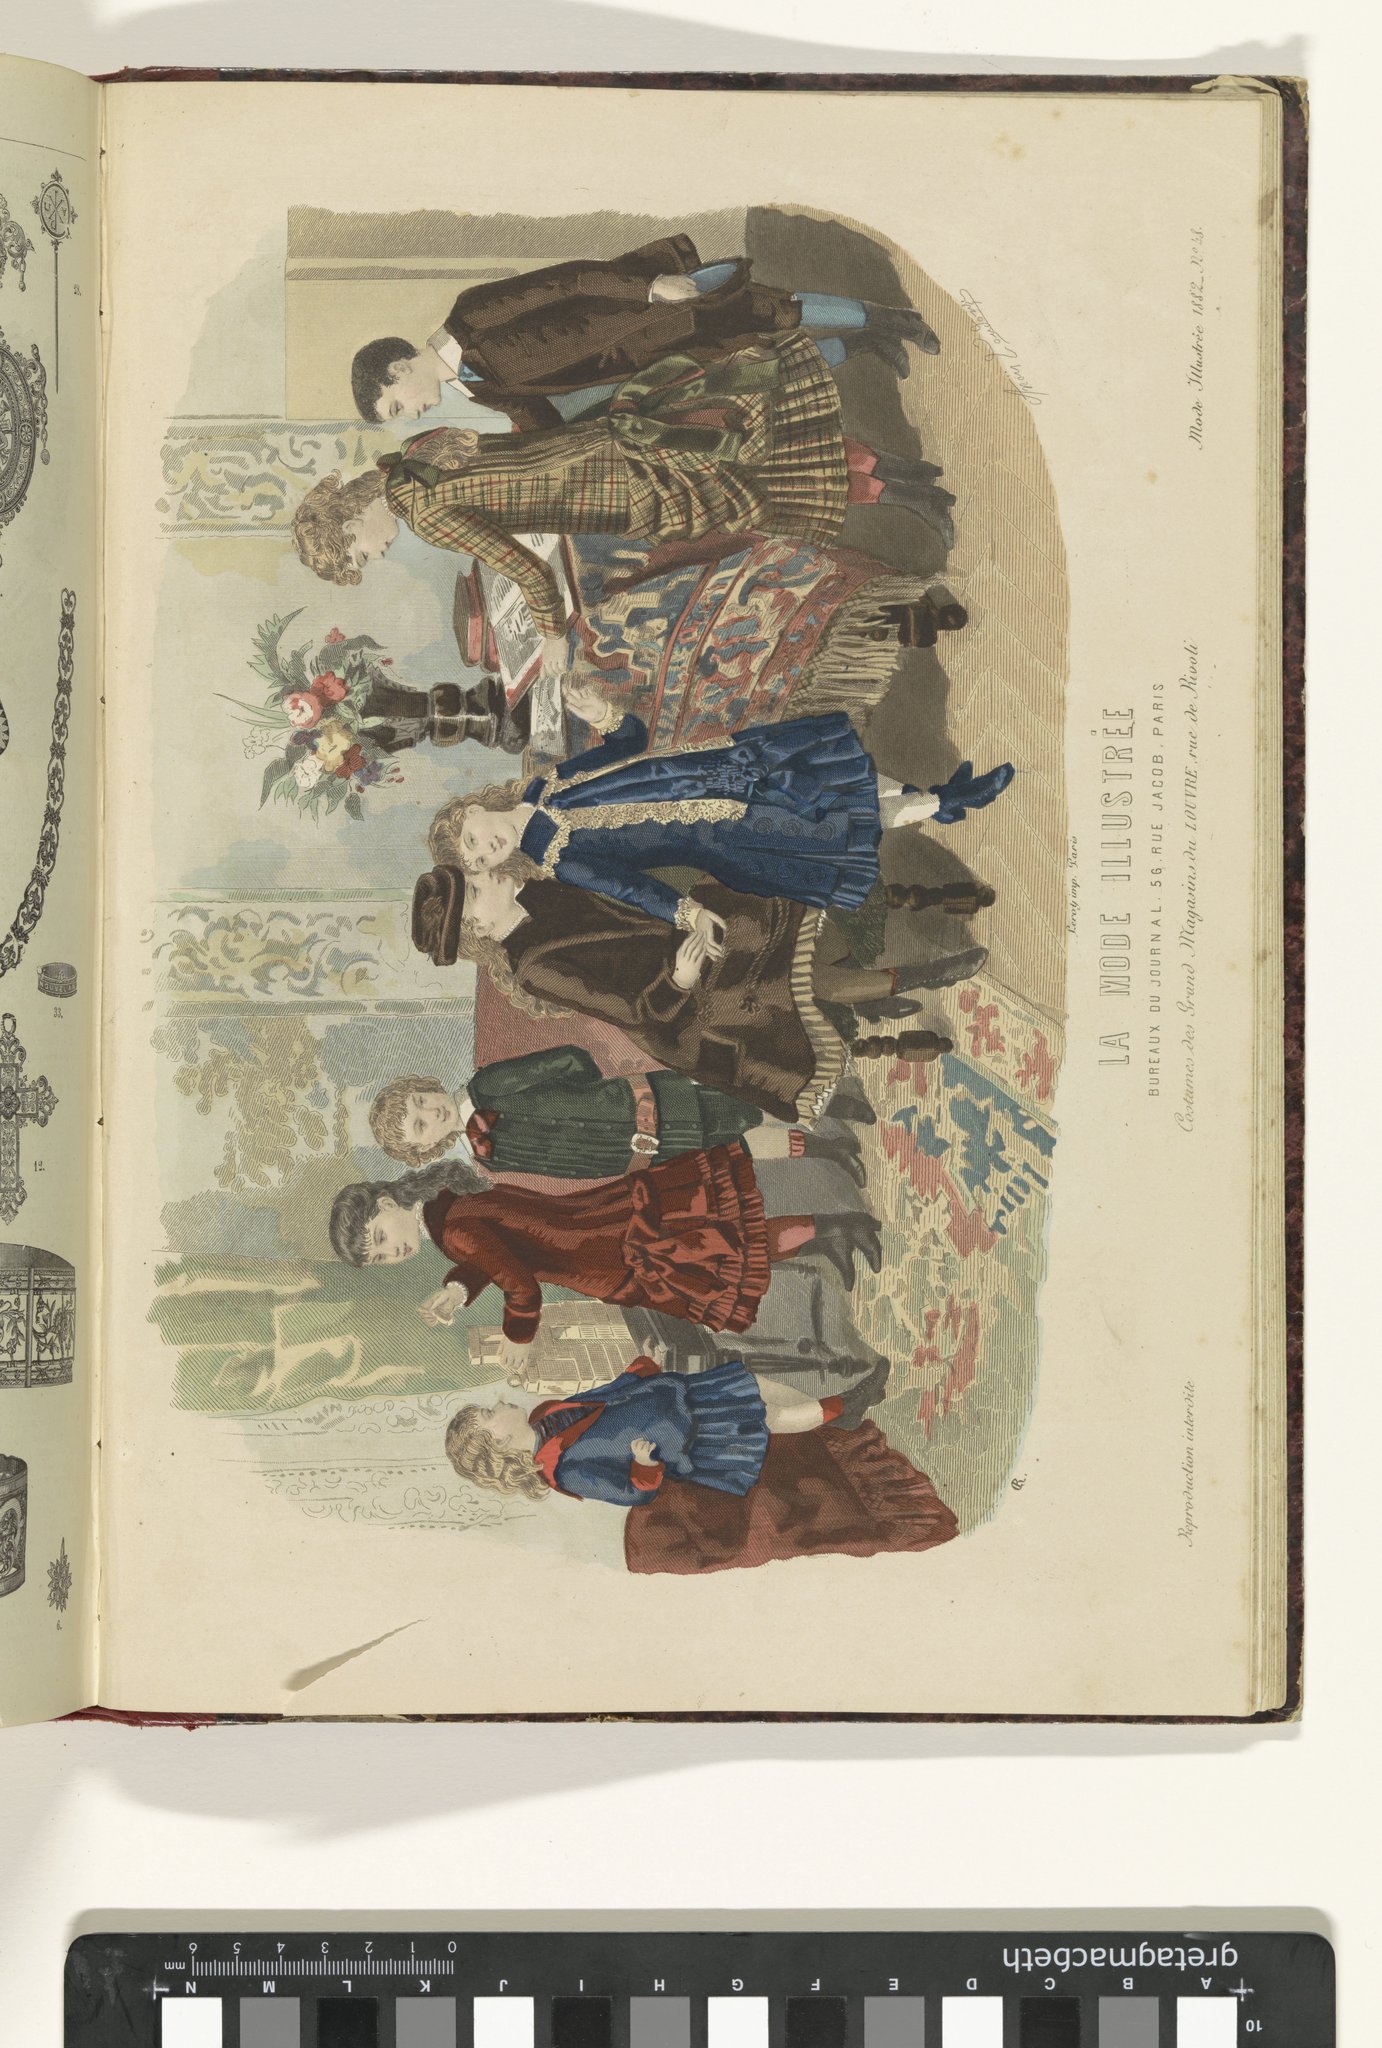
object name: magazine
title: La Mode Illustrée, Journal de la Famille, 1882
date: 1882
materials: paper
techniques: engraving, hand coloring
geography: paris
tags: fashion plates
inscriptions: date